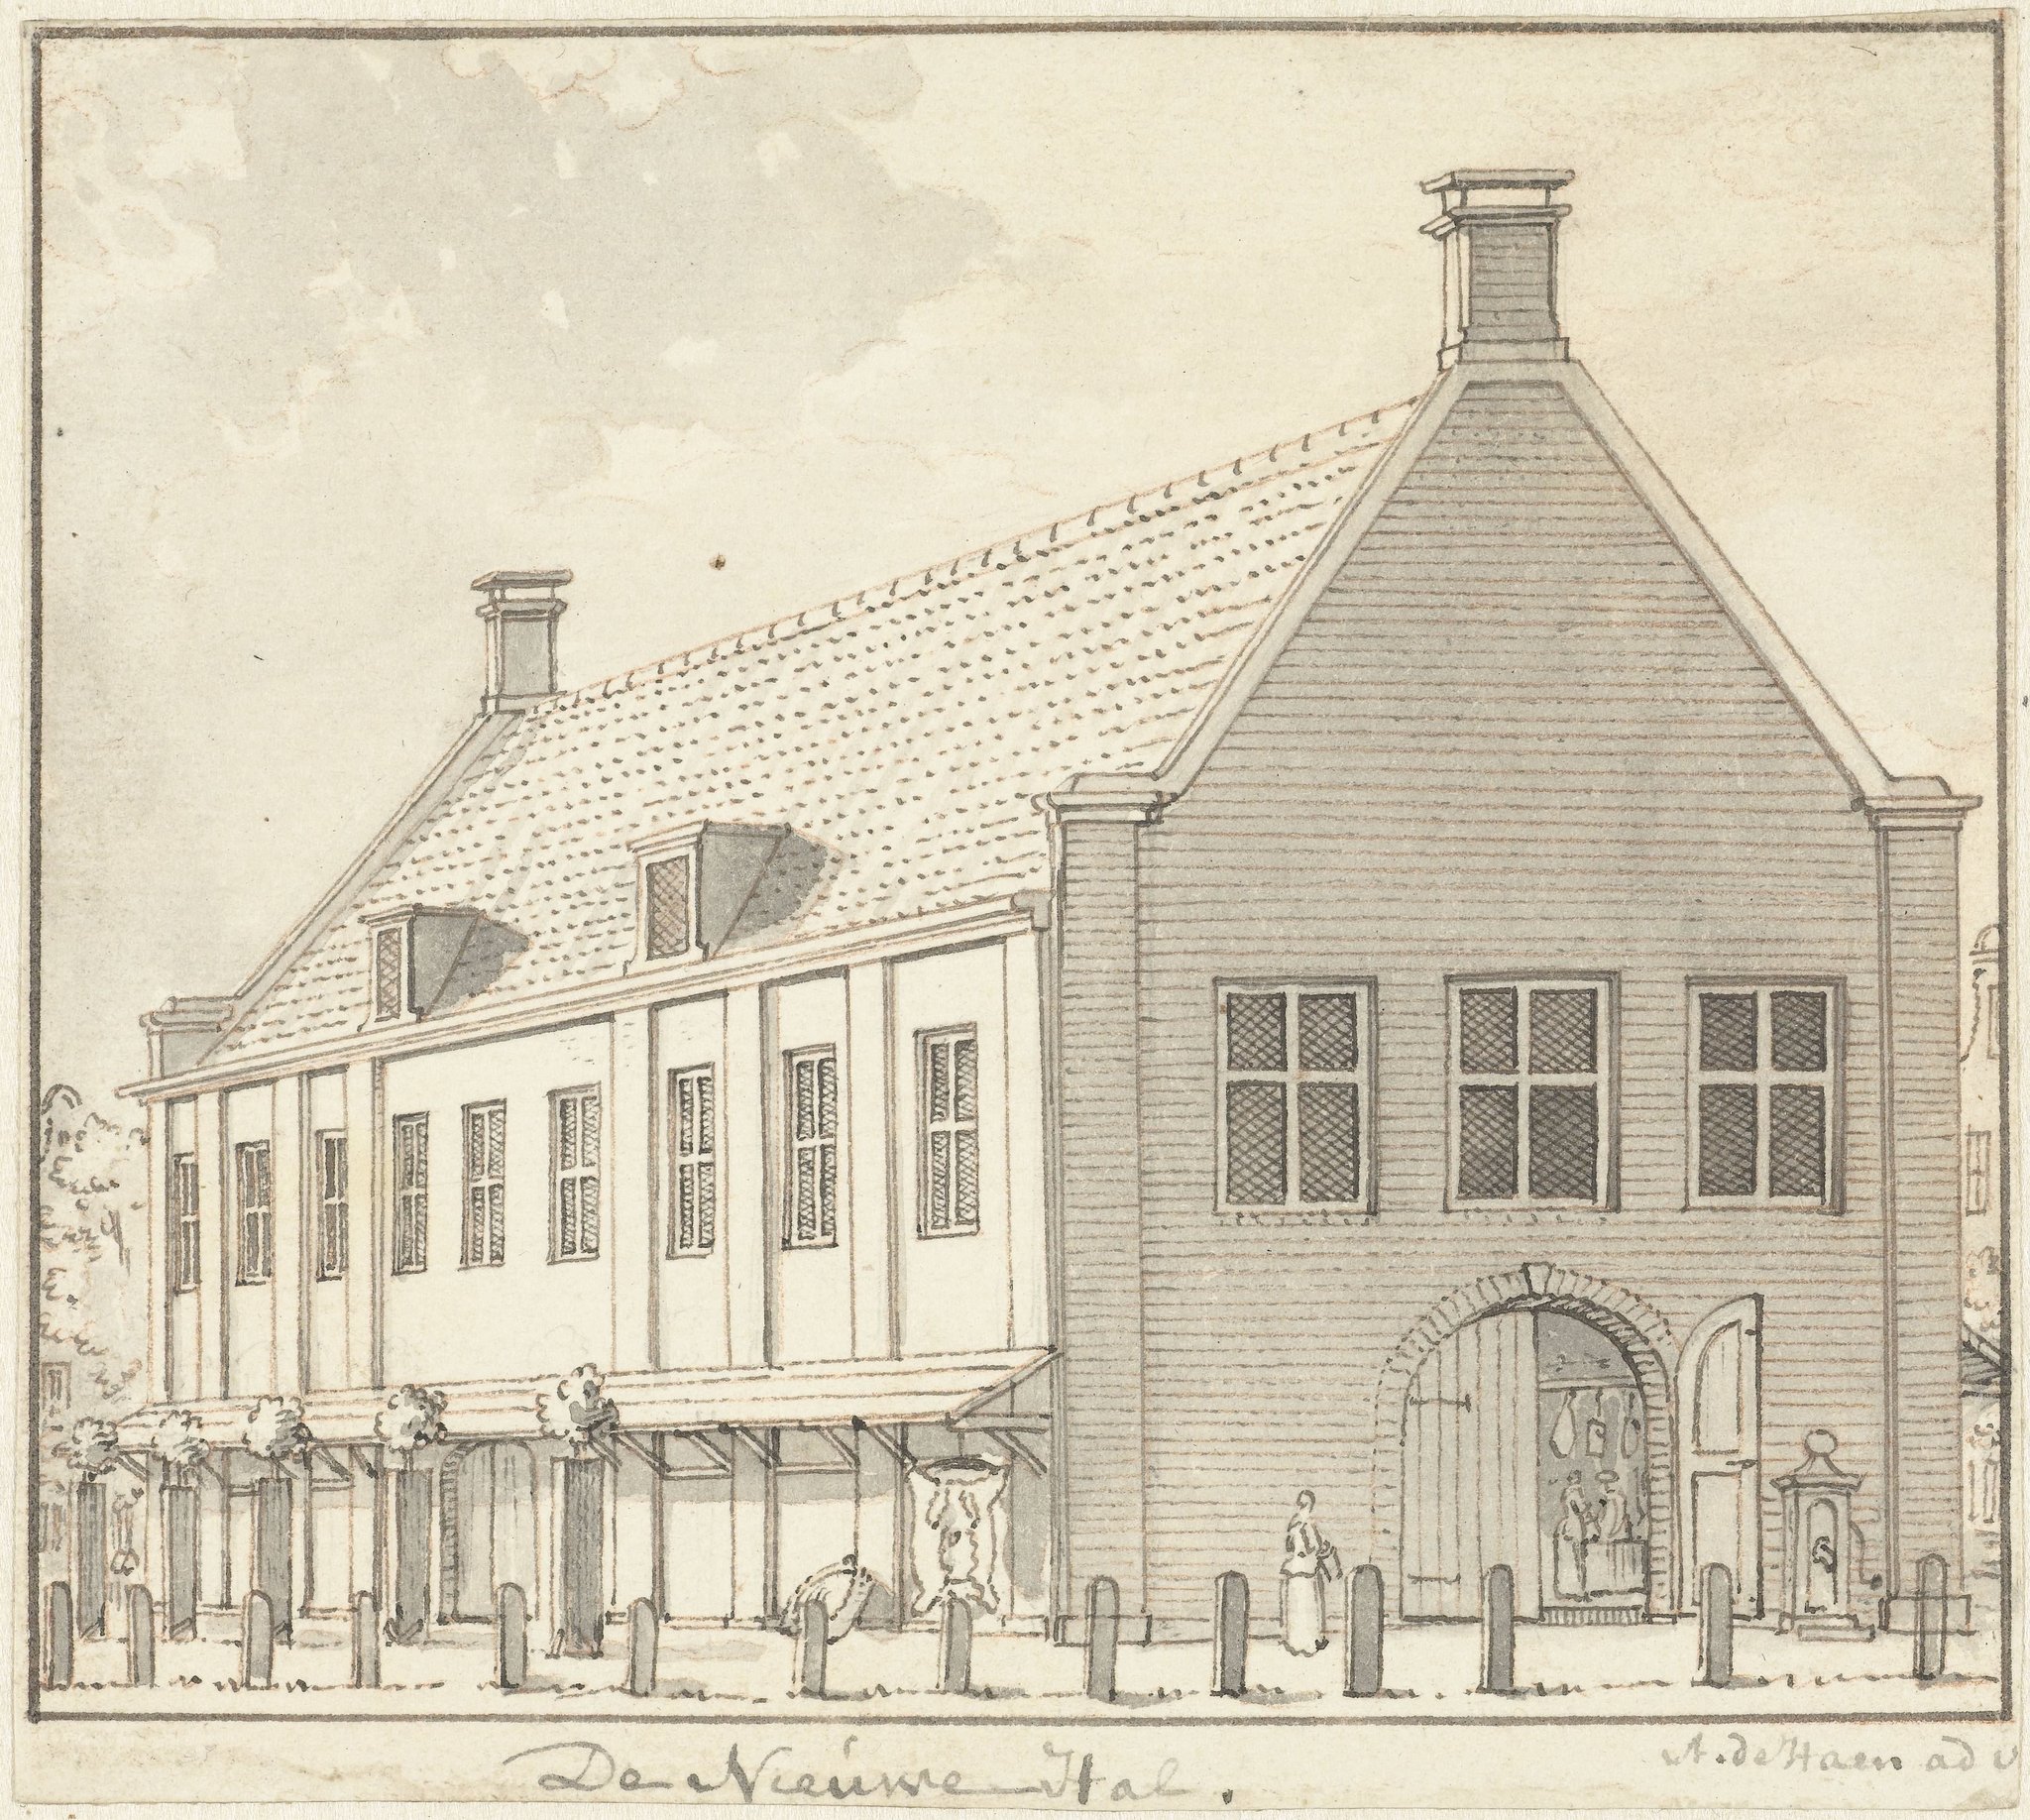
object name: drawing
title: De Nieuwe Hal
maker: abraham de haen (ii)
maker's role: draughtsman, print maker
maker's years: 1707-1748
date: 1717-1748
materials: chalk, ink, paper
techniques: brush, pen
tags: amsterdam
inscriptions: inscription: ‘De Nieuwe Hal’